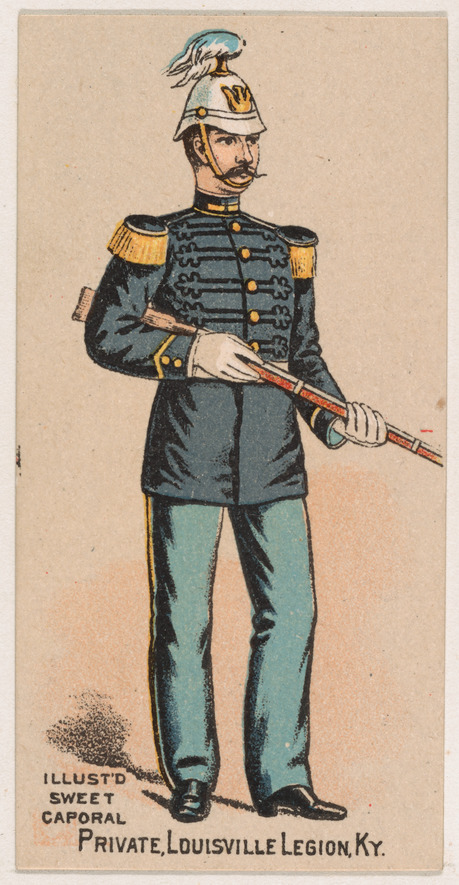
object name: print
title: Private, Louisville Legion, Kentucky, from the Military Series (N224) issued by Kinney Tobacco Company to promote Sweet Caporal Cigarettes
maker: kinney brothers tobacco company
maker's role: publisher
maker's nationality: american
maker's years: 1869-2011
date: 1888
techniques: color lithograph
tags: soldiers,firearms,men